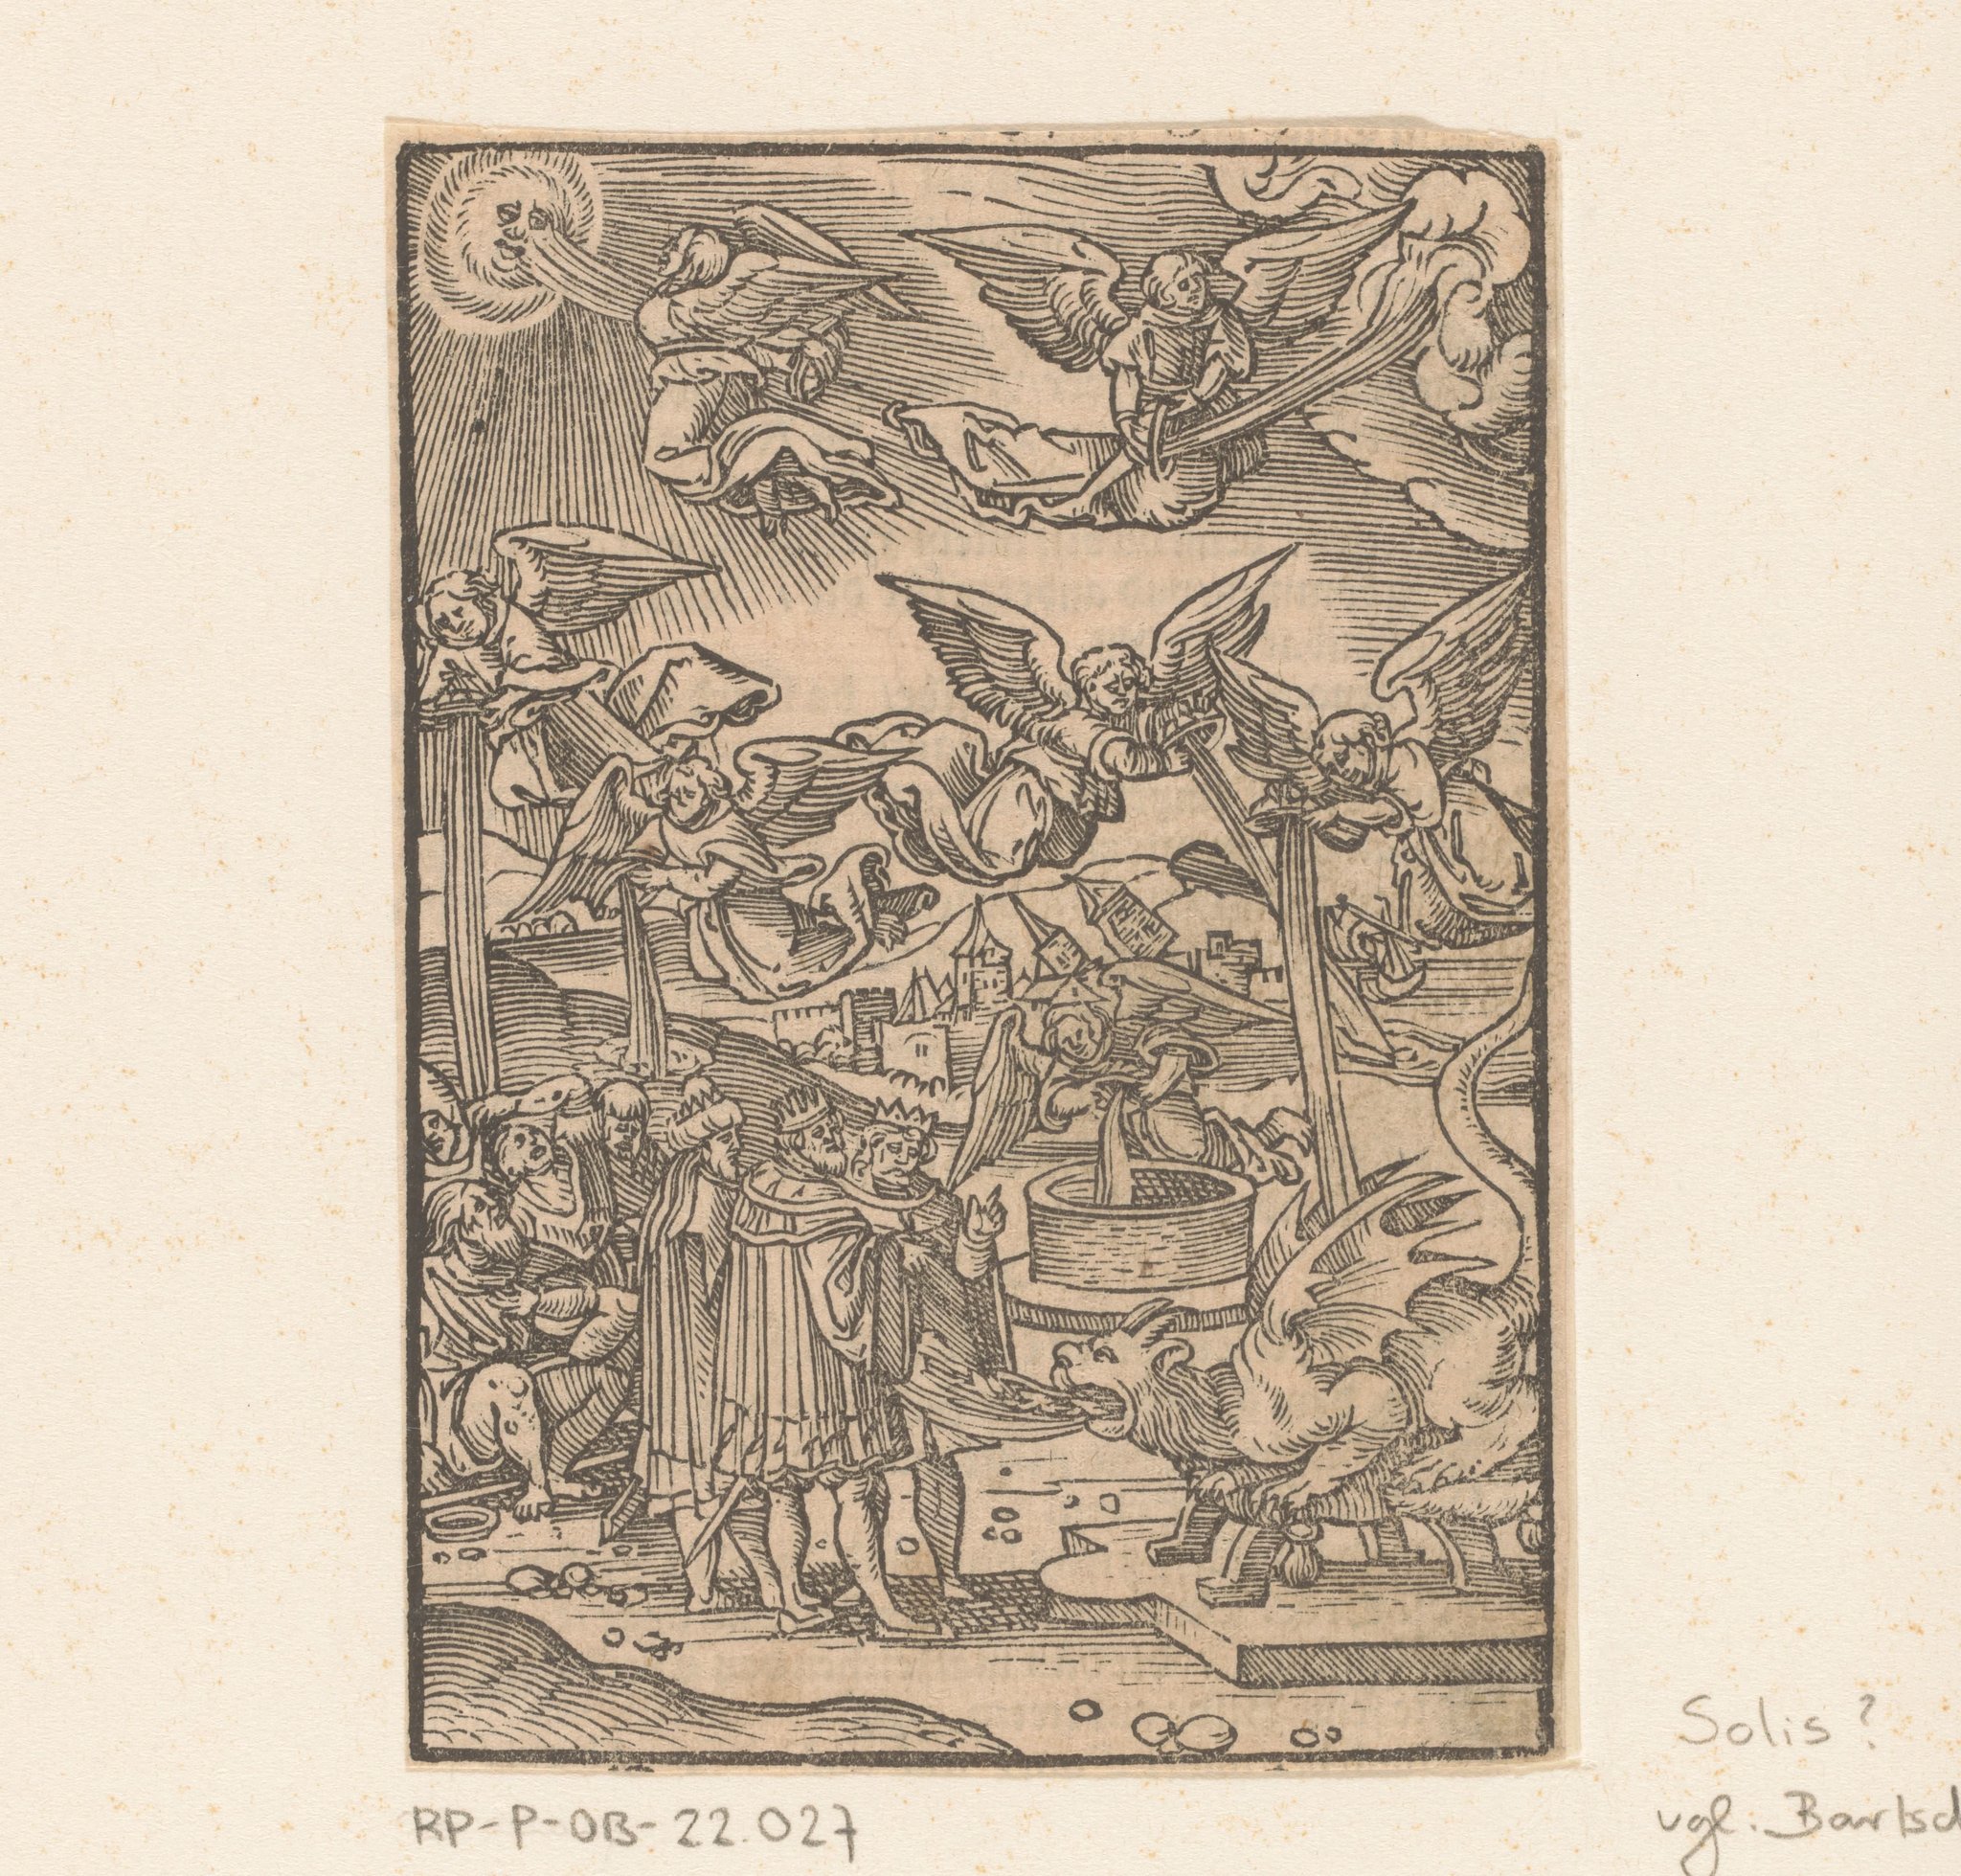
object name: print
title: Zeven plagen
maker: Anonymous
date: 1565-1612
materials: paper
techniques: woodcut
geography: nuremberg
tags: the seven angels with the seven vials, bringing disasters and destruction upon the earth and mankind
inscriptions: number: ‘347’, number: ‘183’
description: Engelen gieten schalen leeg die plagen veroorzaken. Op de voorgrond de zesde plaag: een draak die kikkers braakt.